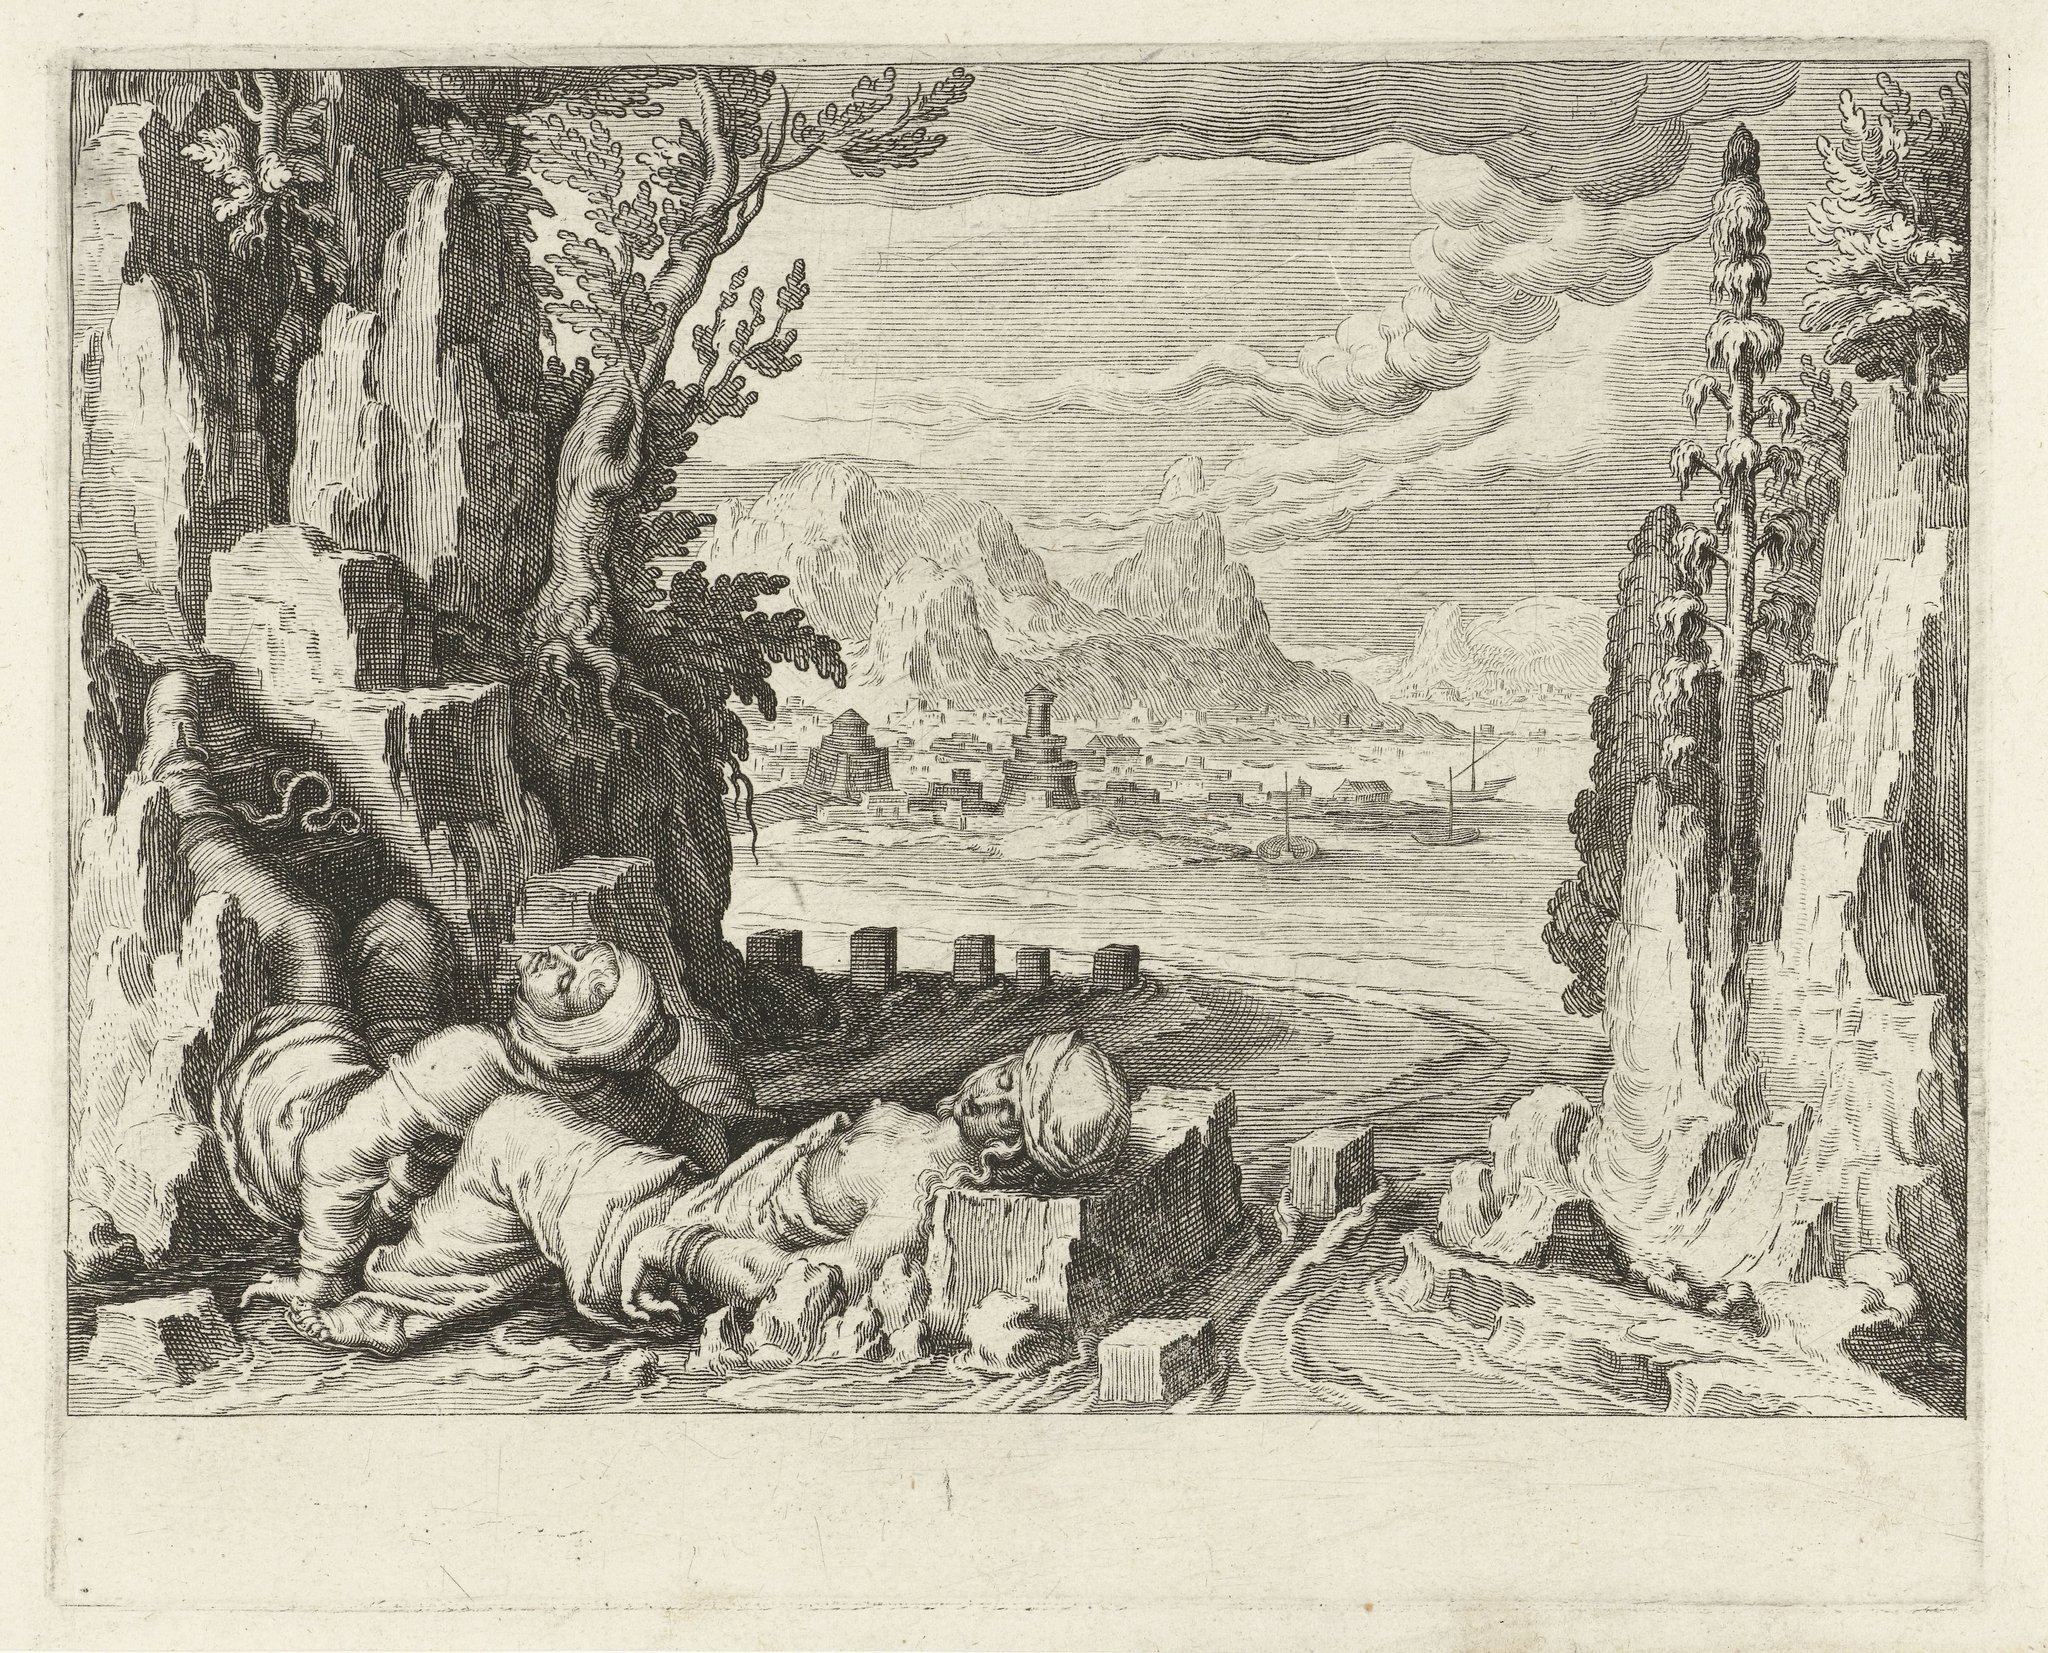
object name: print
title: Een vissersvrouw verdrinkt zich samen met haar ongeneeslijk zieke man in zee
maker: zacharias dolendo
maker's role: print maker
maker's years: 1561-1604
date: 1606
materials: paper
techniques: engraving, letterpress printing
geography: leiden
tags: death by drowning (non-violent), self-sacrifice, death in the service of a higher purpose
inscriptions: collector's mark: Lugt 2228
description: Een vissersvrouw verdrinkt zichzelf en haar man in zee om hen beiden te verlossen van het lijden en de pijn. De vissersvrouw ligt met haar hoofd op een steen, op haar rug in het water. Haar man ligt met zijn rug op haar benen en met zijn benen tegen een rots aan. Bladzijde uit een boek met tekst op het verso.